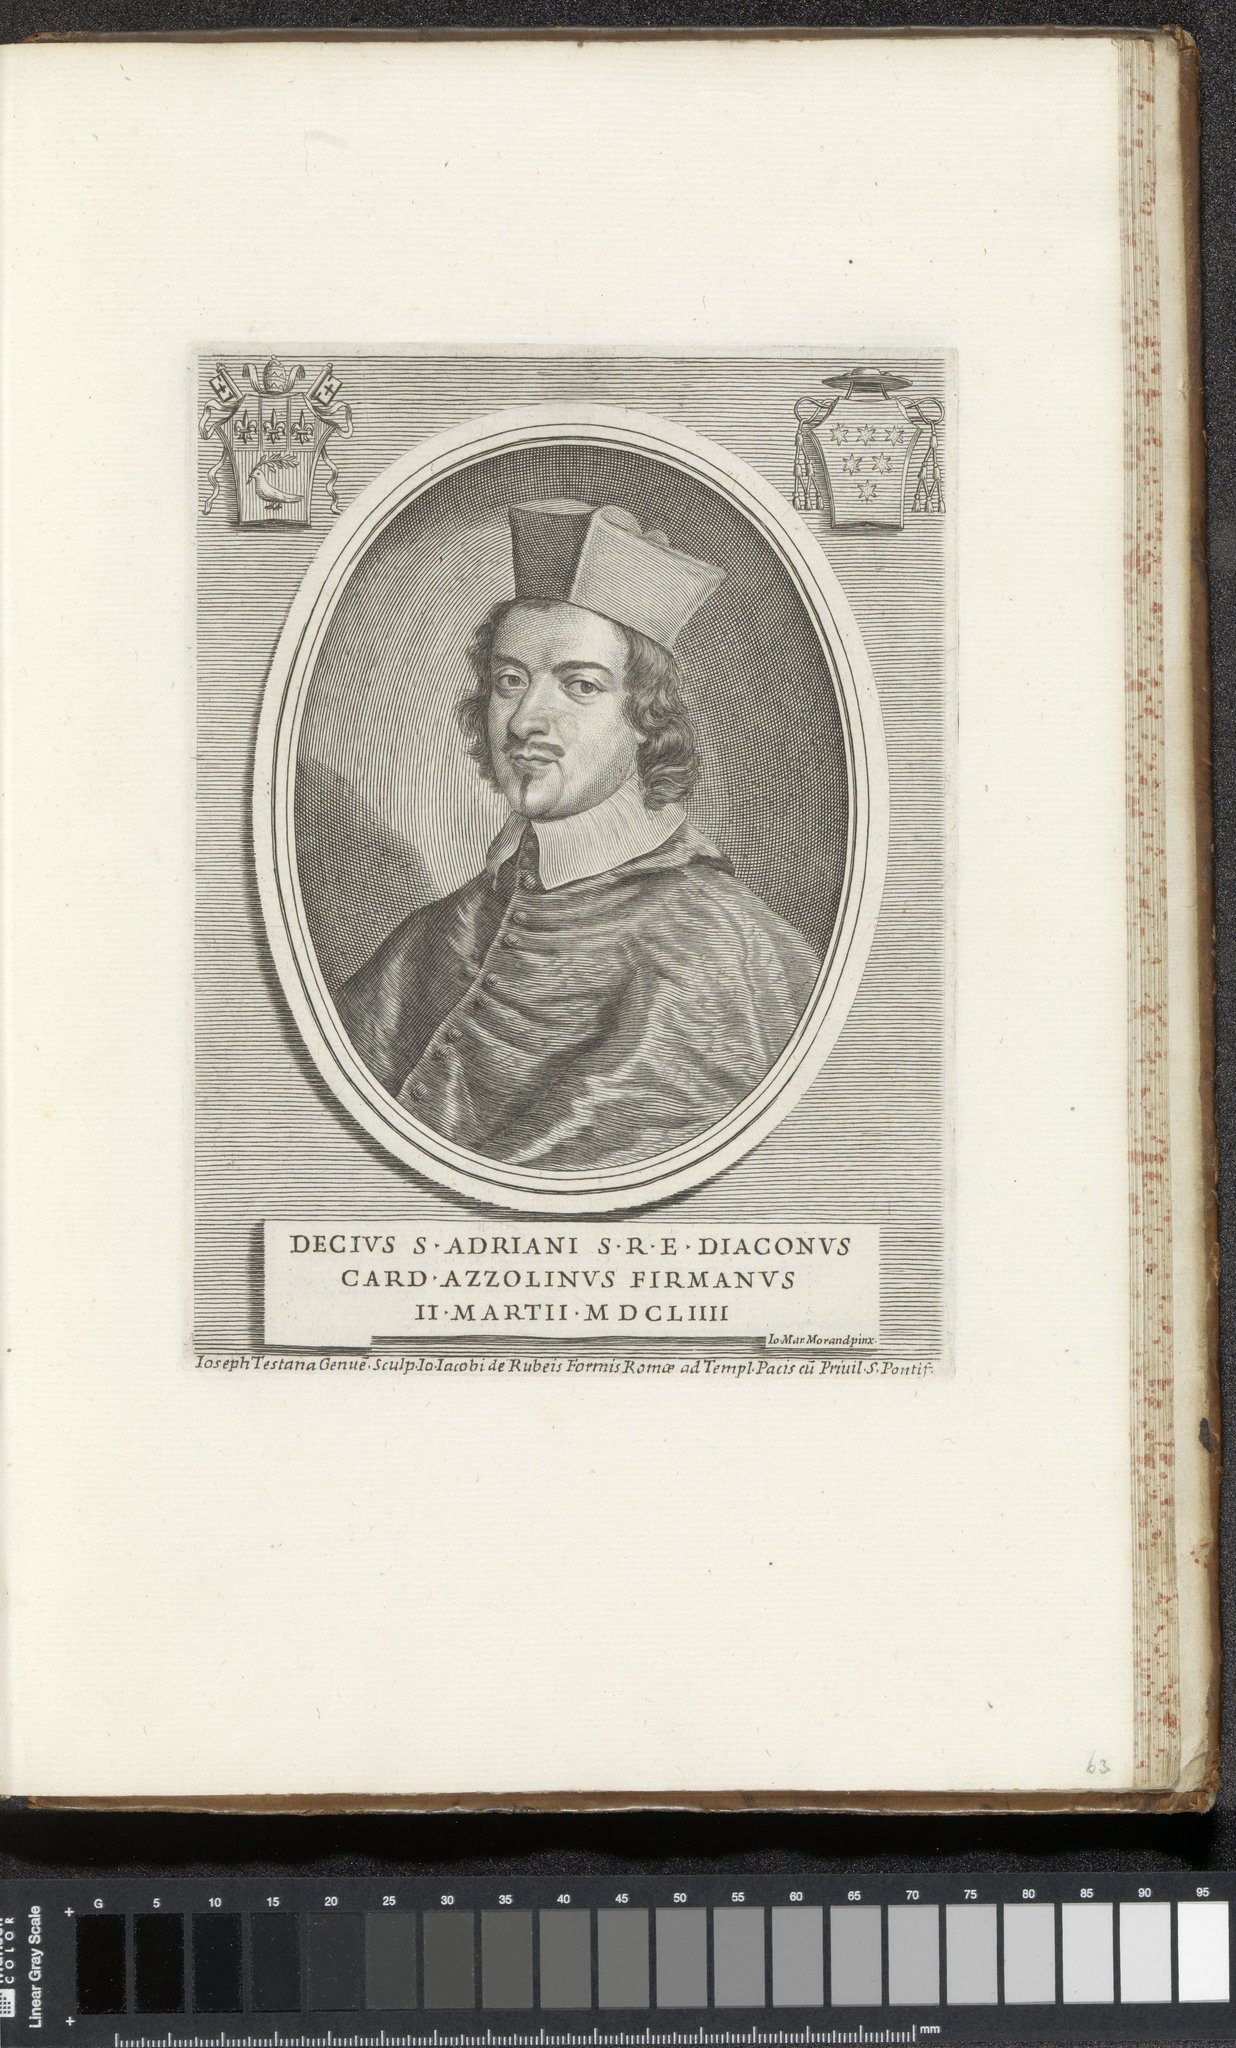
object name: album leaf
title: Portret van kardinaal Decio Azzolini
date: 1658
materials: paper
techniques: engraving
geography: rome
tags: rome, decio azzolini, cardinal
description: Portret van kardinaal Decio Azzolini. Linksboven het wapen van paus Innocentius X en rechtsboven het wapen van de kardinaal. Onderaan een onderschrift in het Latijn. De prent maakt deel uit van een album.